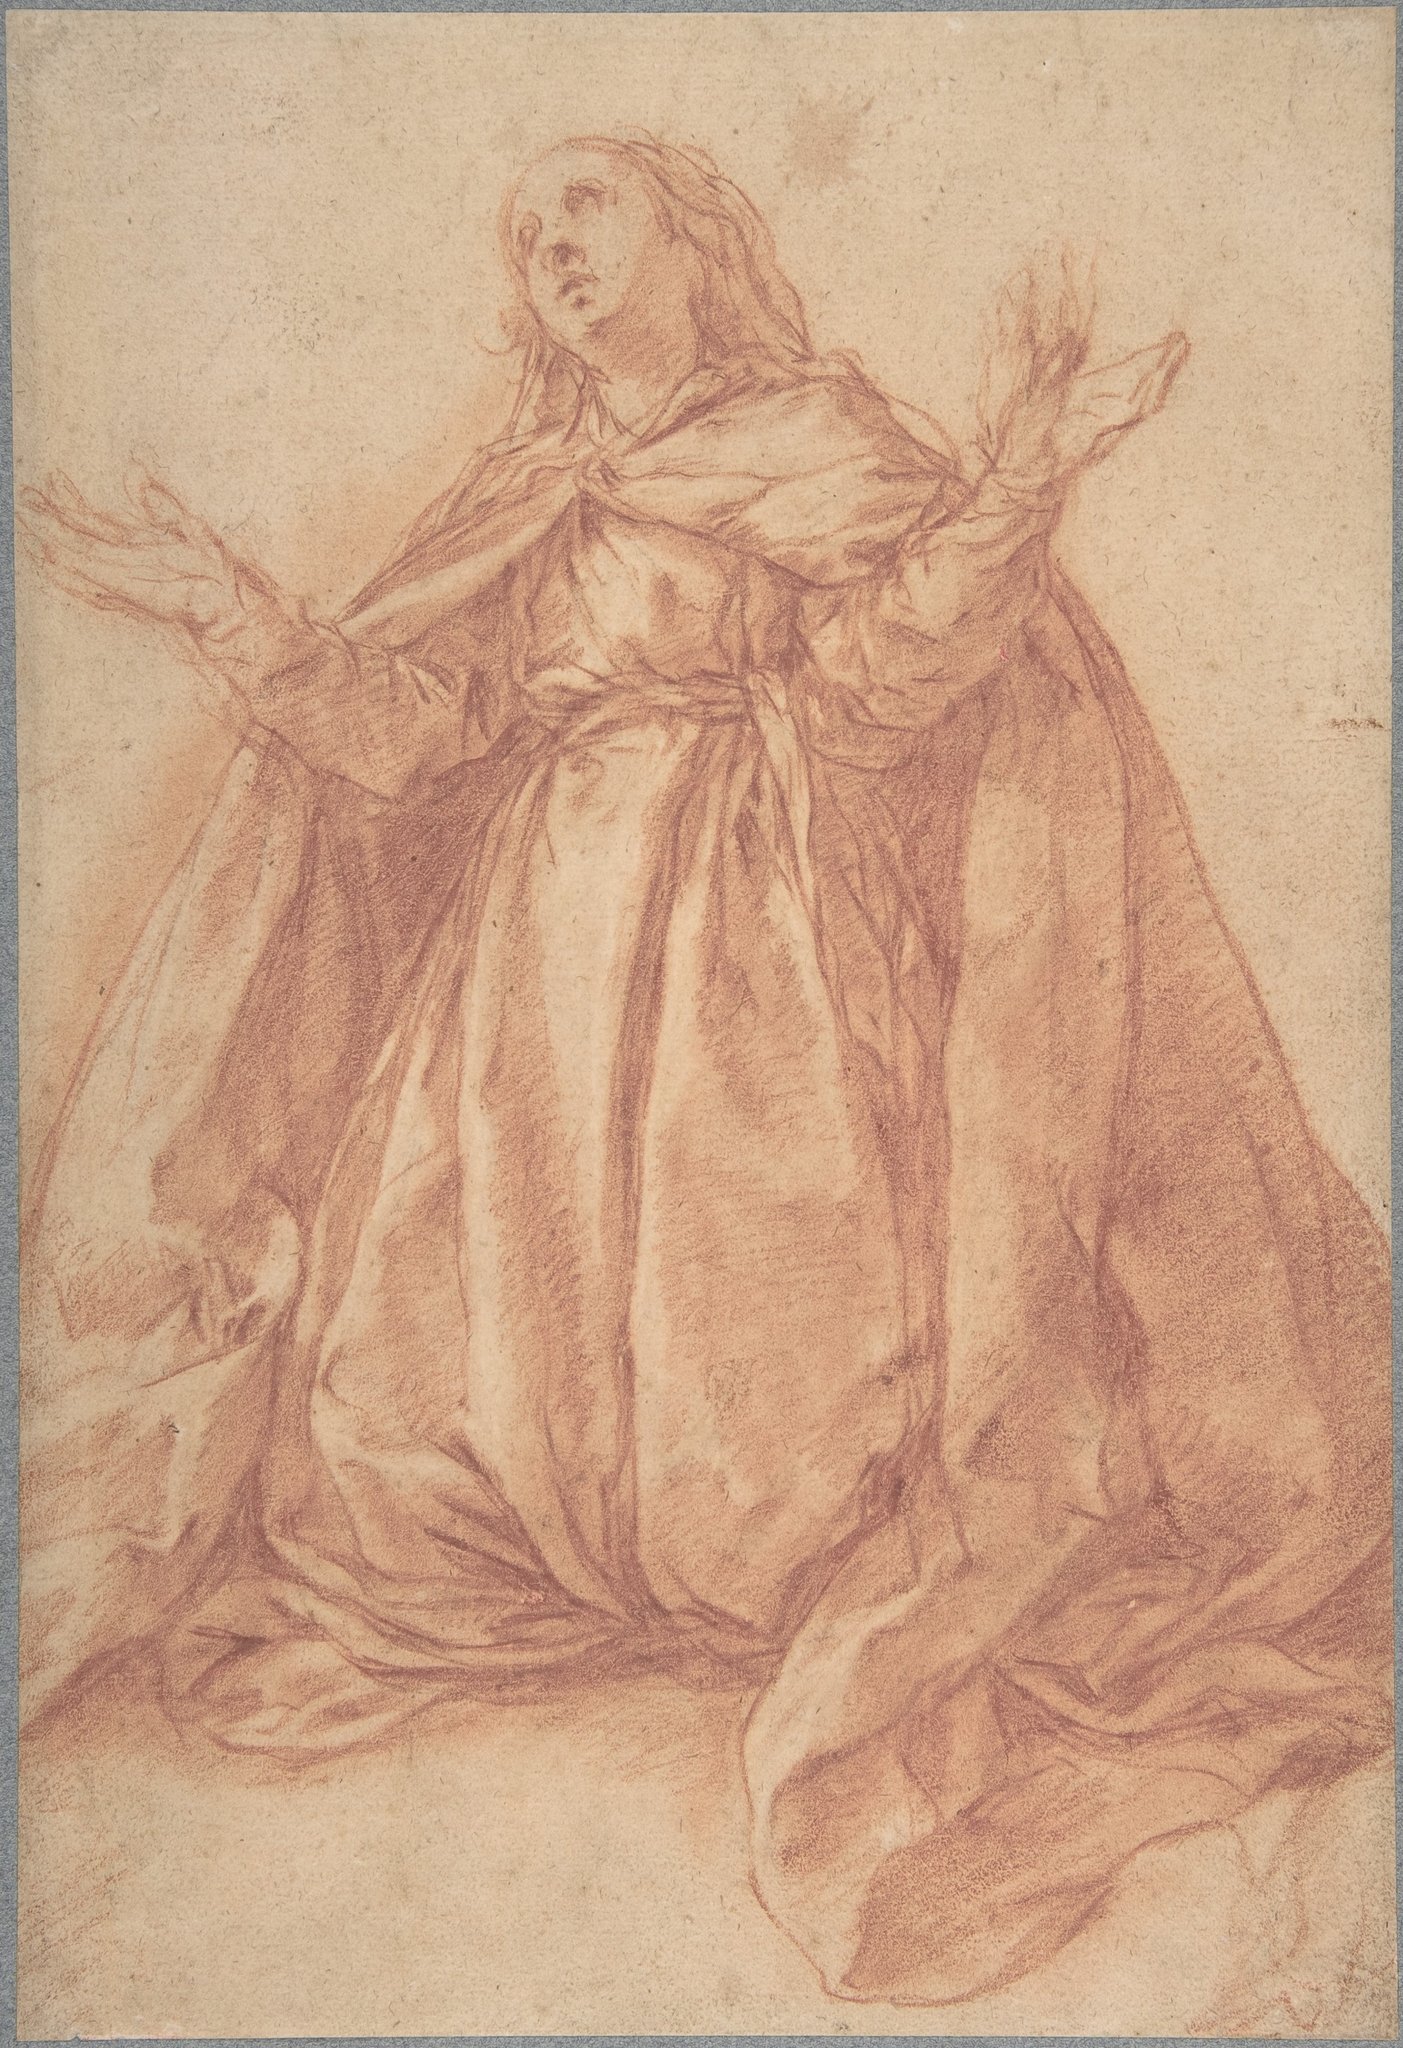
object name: drawing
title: Kneeling Female Figure with Upraised Arms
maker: abraham bloemaert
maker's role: artist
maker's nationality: netherlandish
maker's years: 1566-1651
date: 1567-1666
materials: chalk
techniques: heightening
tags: women